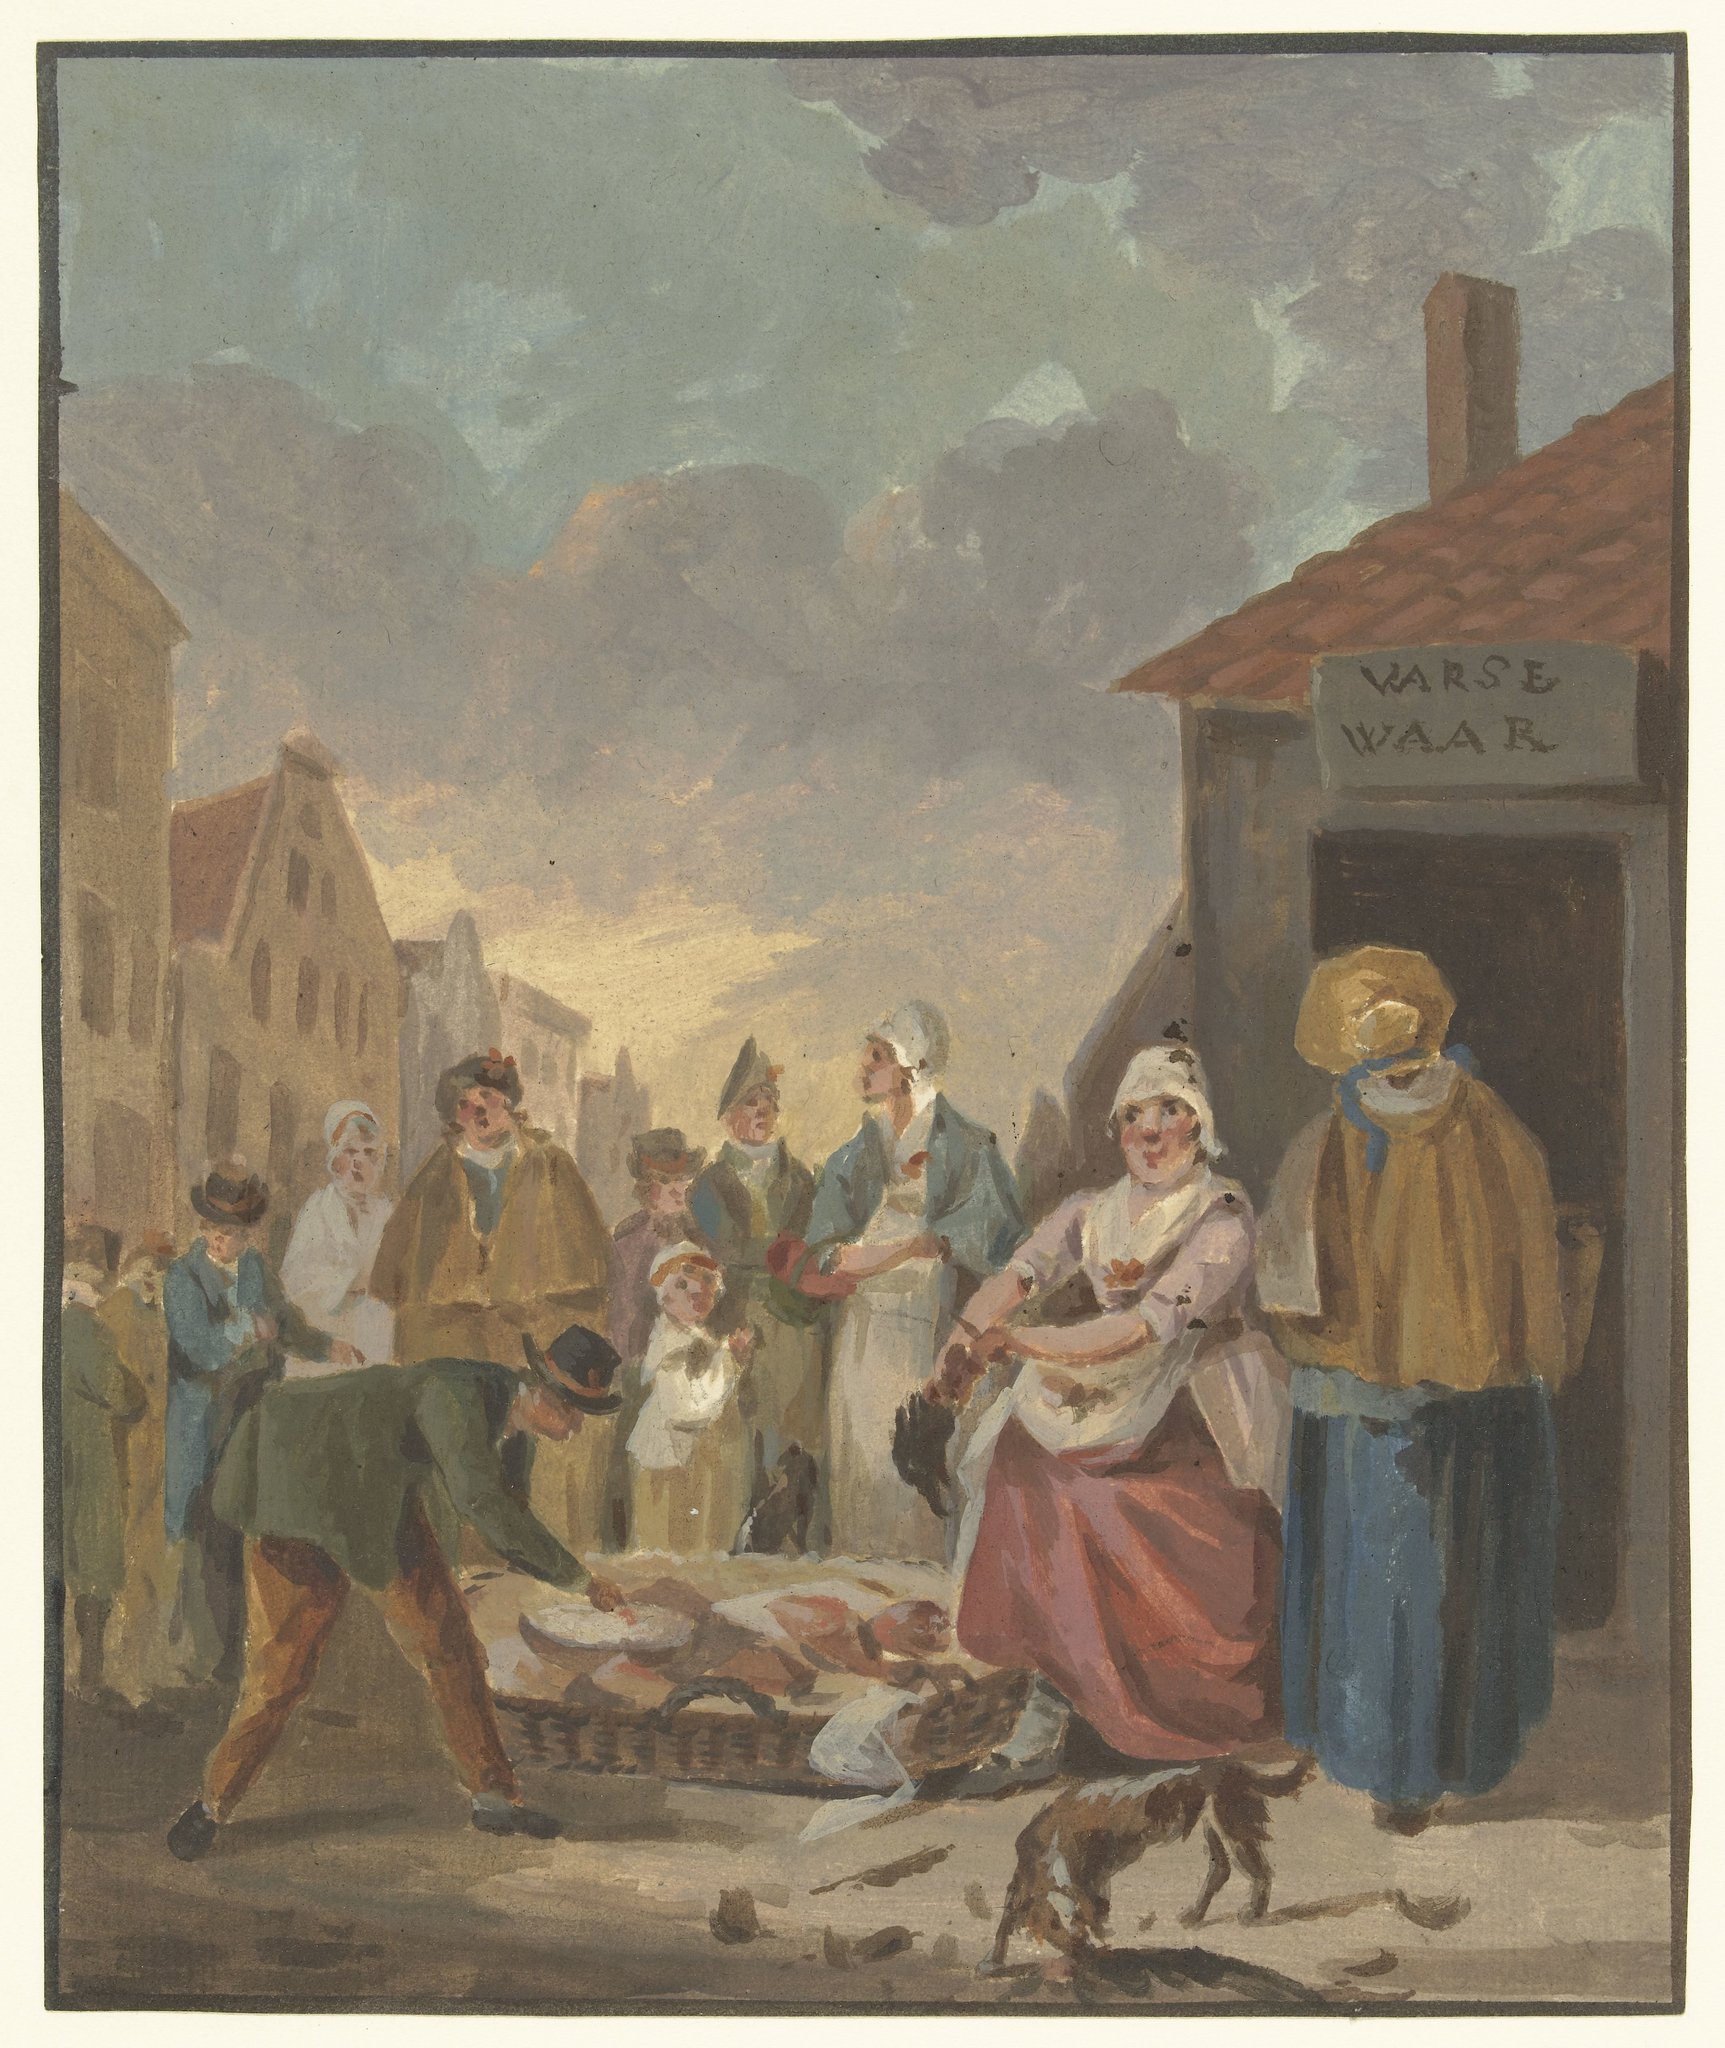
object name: drawing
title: Varse waar van den Adelaar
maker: Anonymous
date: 1811-1813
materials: paint, paper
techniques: brush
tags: shop, store, meat; still life of meat, historical events and situations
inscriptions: : ‘Varse waar’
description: Een marktvrouw biedt het publiek vlees te koop aan.